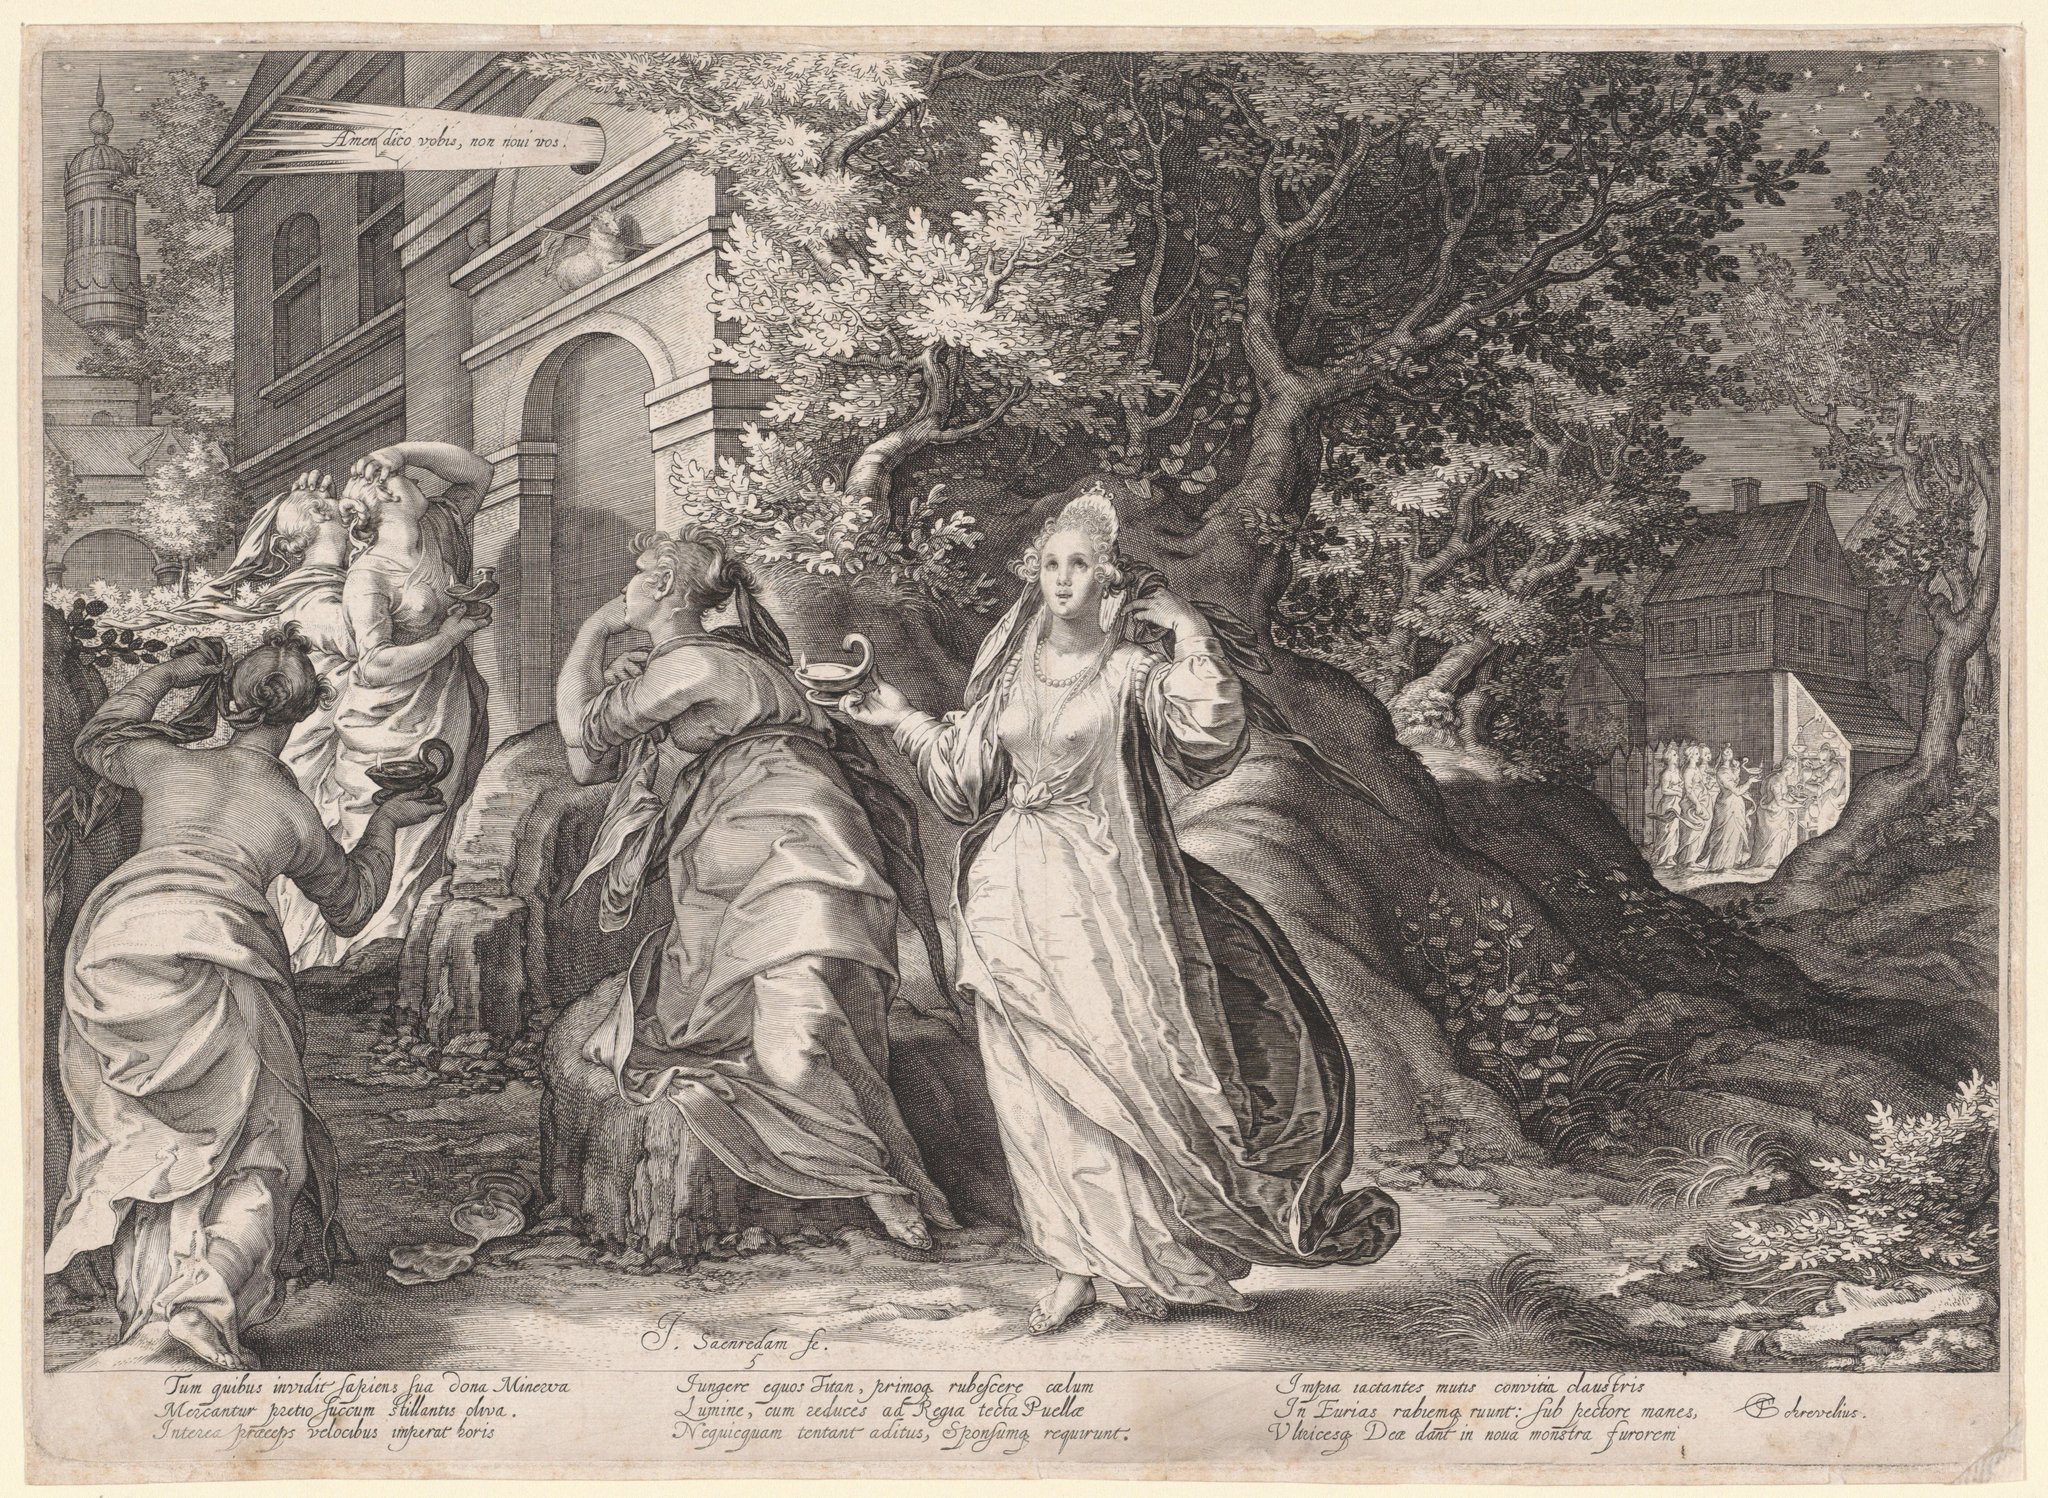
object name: print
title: Vijf dwaze maagden worden niet ontvangen door de heer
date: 1606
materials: paper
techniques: engraving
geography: assendelft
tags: the wise virgins are let into the house with the bridegroom (christ); the foolish virgins are shut out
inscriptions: collector's mark: Lugt 2228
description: De vijf dwaze maagden voor de toegangspoort van het huis van de bruidegom. Ze worden niet toegelaten. Boven de toegangspoort het Lam Gods. Op de achtergrond vullen de vijf dwaze maagden hun olielampen bij een marktkramer. De prent heeft een Latijns onderschrift.